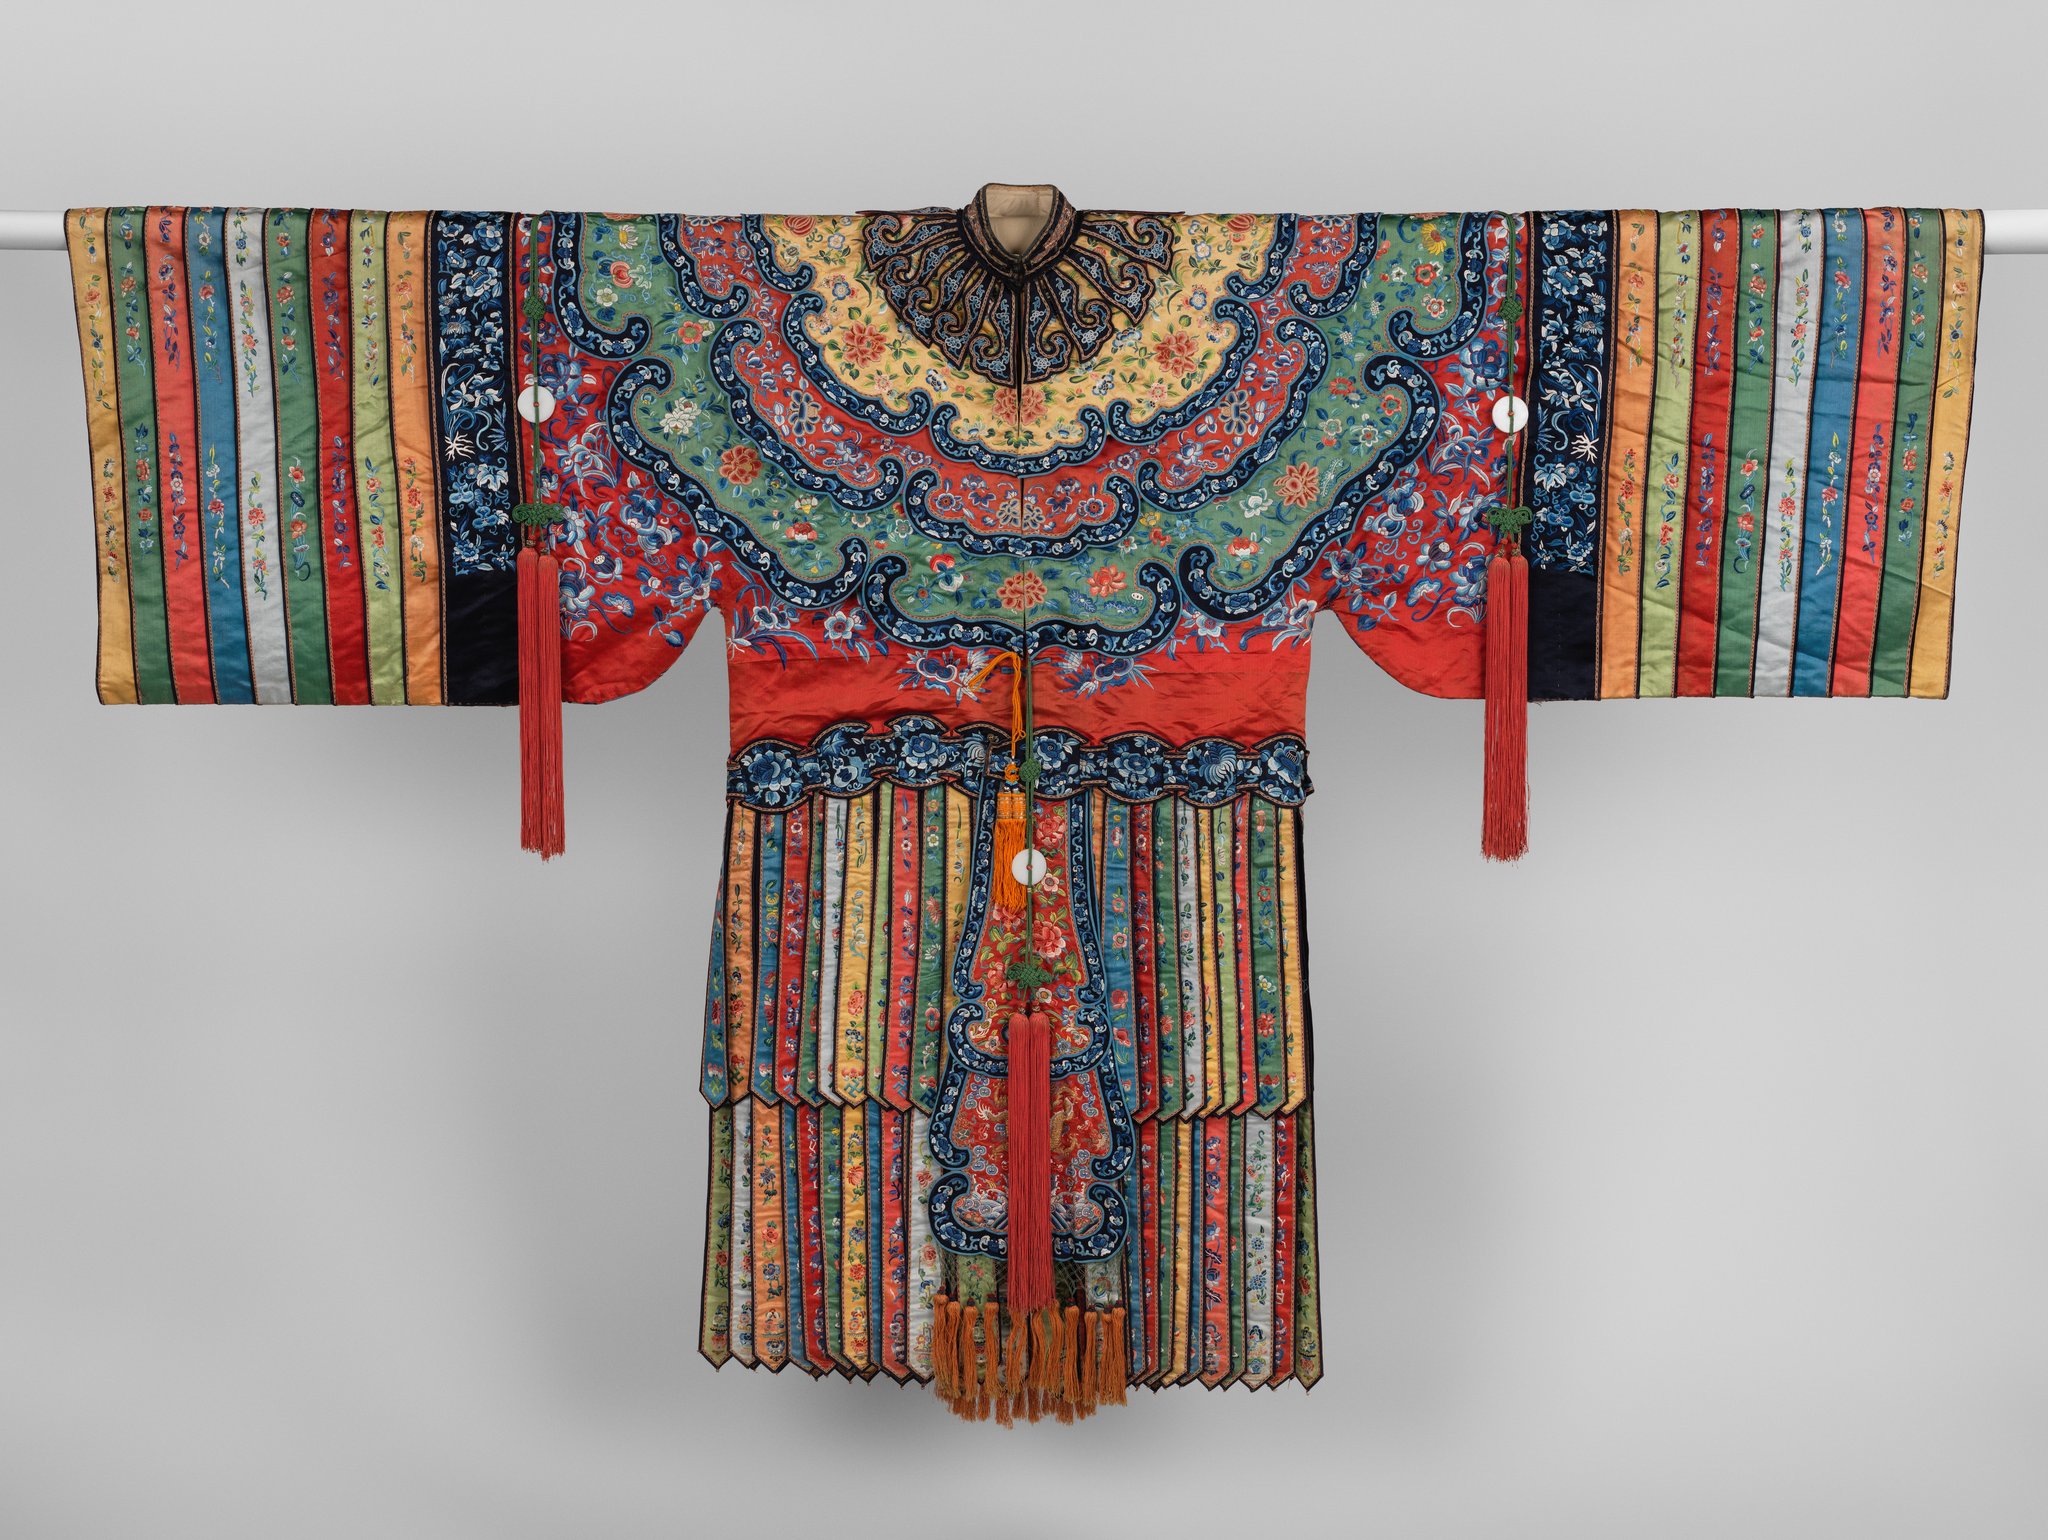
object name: robe, theatrical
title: Theatrical Robe for the Role of a Princess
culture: chinese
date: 1867-1900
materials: silk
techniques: embroidery